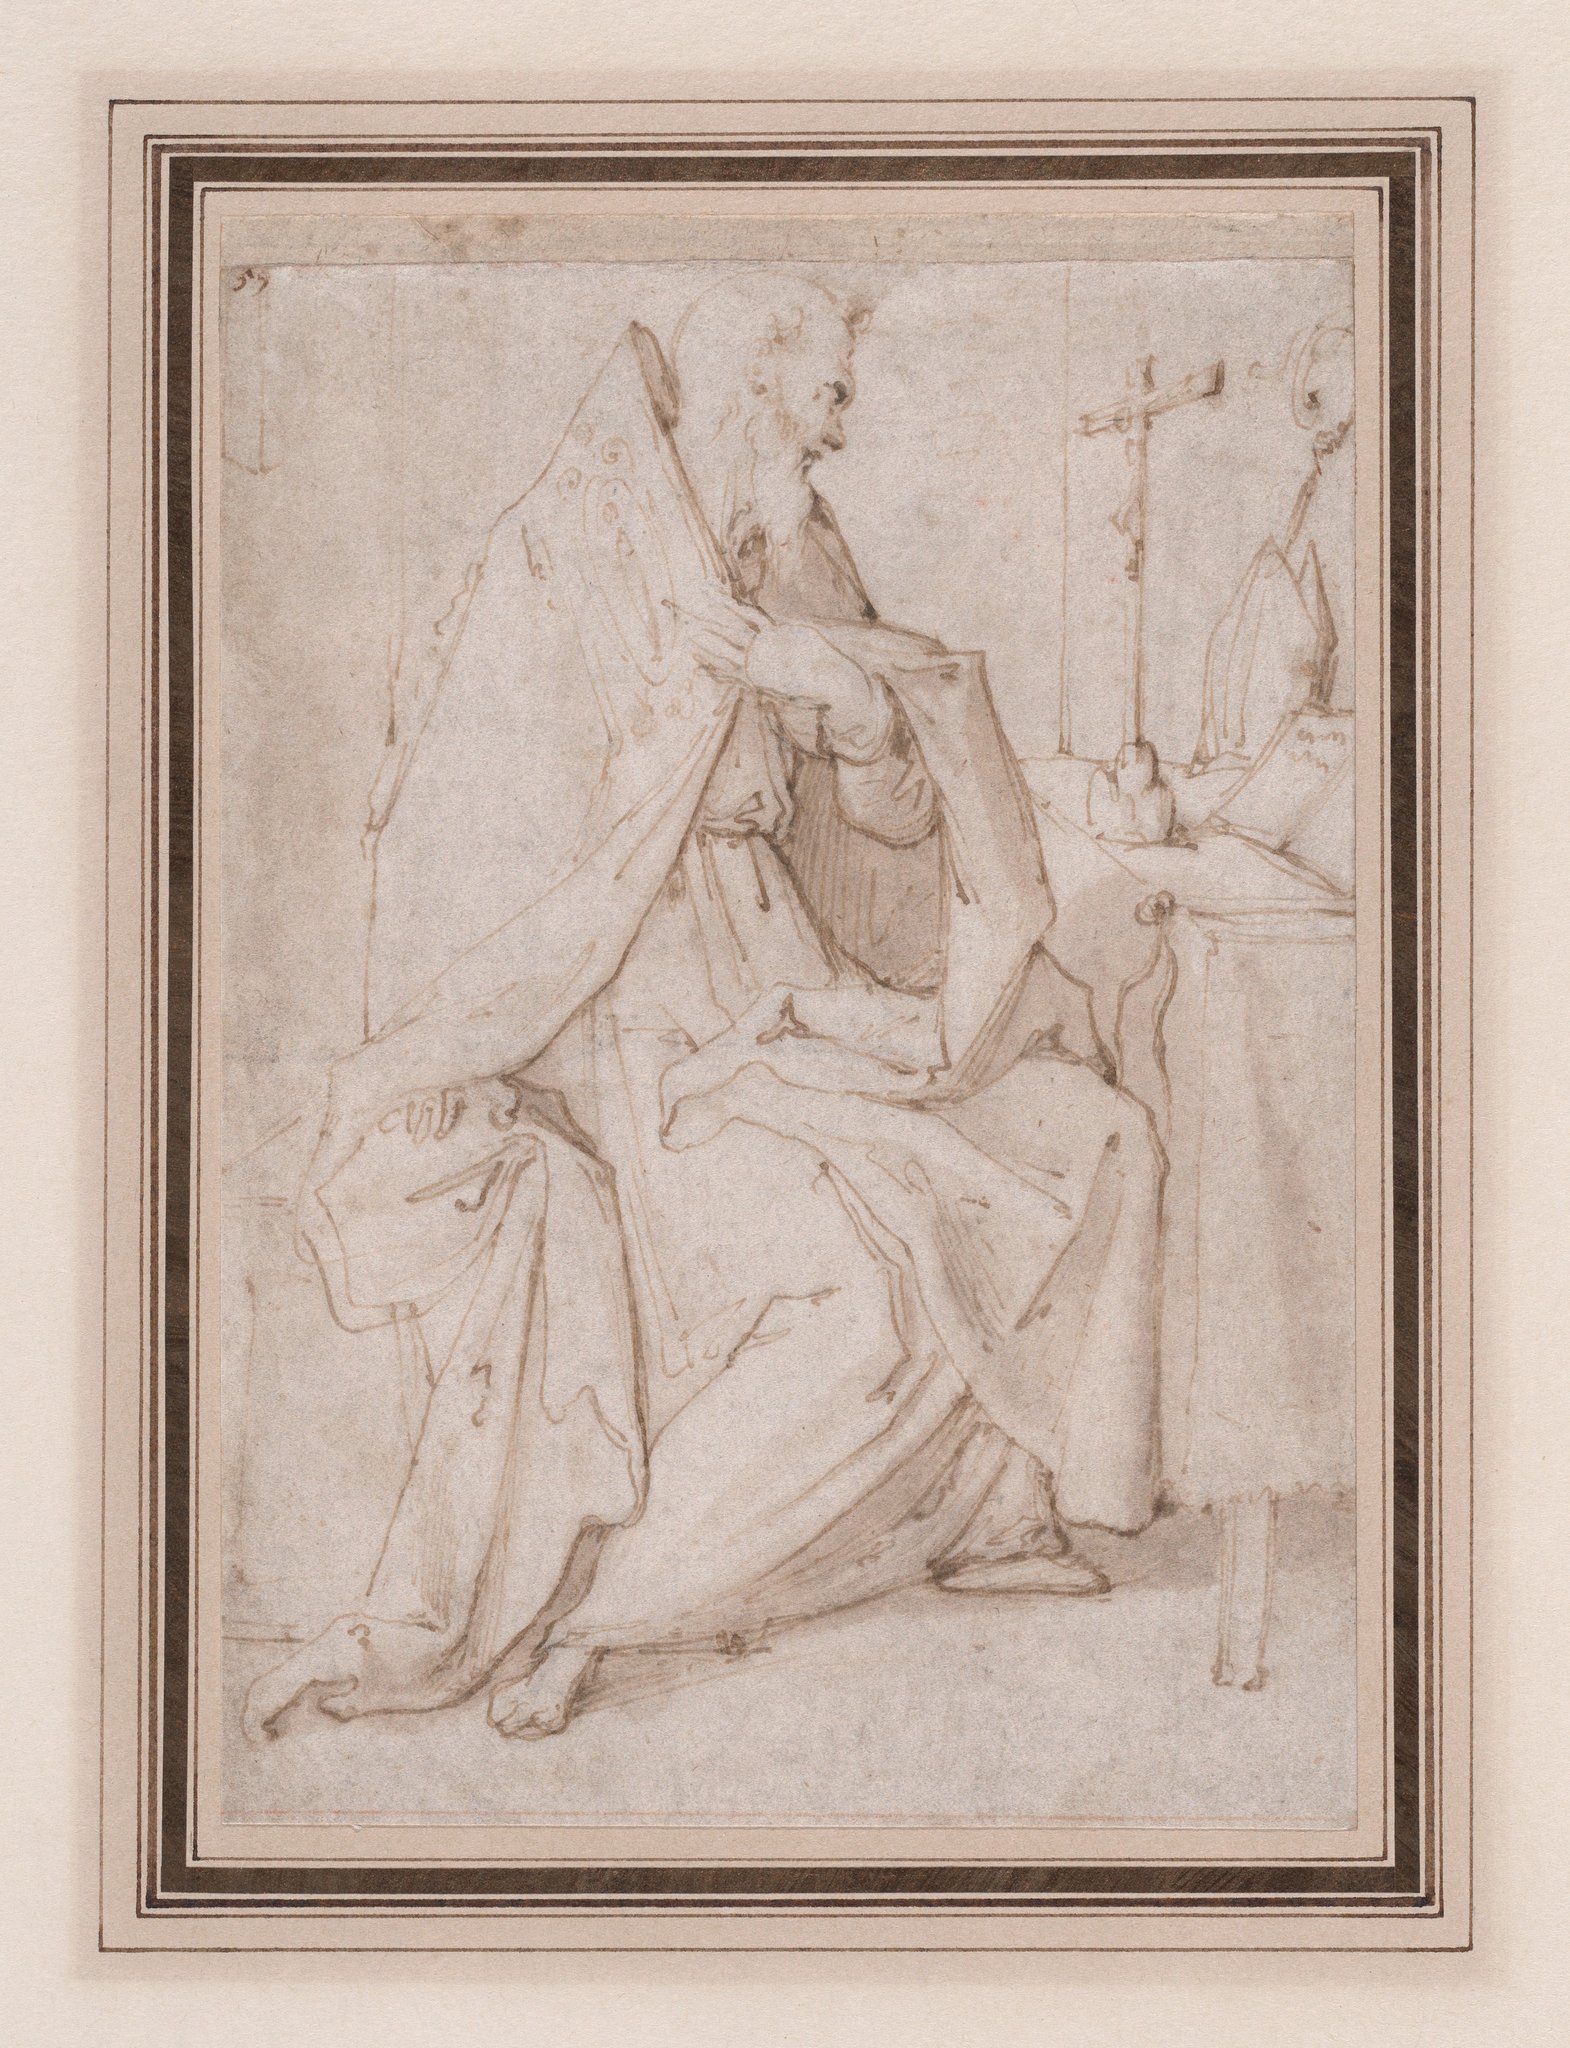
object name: drawing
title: (recto) Seated Bishop Saint Praying Before a Crucifix; (verso) the cropped figure of a youth seen in frontal view (somewhat damaged).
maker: anonymous, spanish, late 16th–early 17th century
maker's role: artist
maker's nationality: spanish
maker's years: 1570-1620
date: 1570-1620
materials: chalk, ink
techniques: inlay, pen